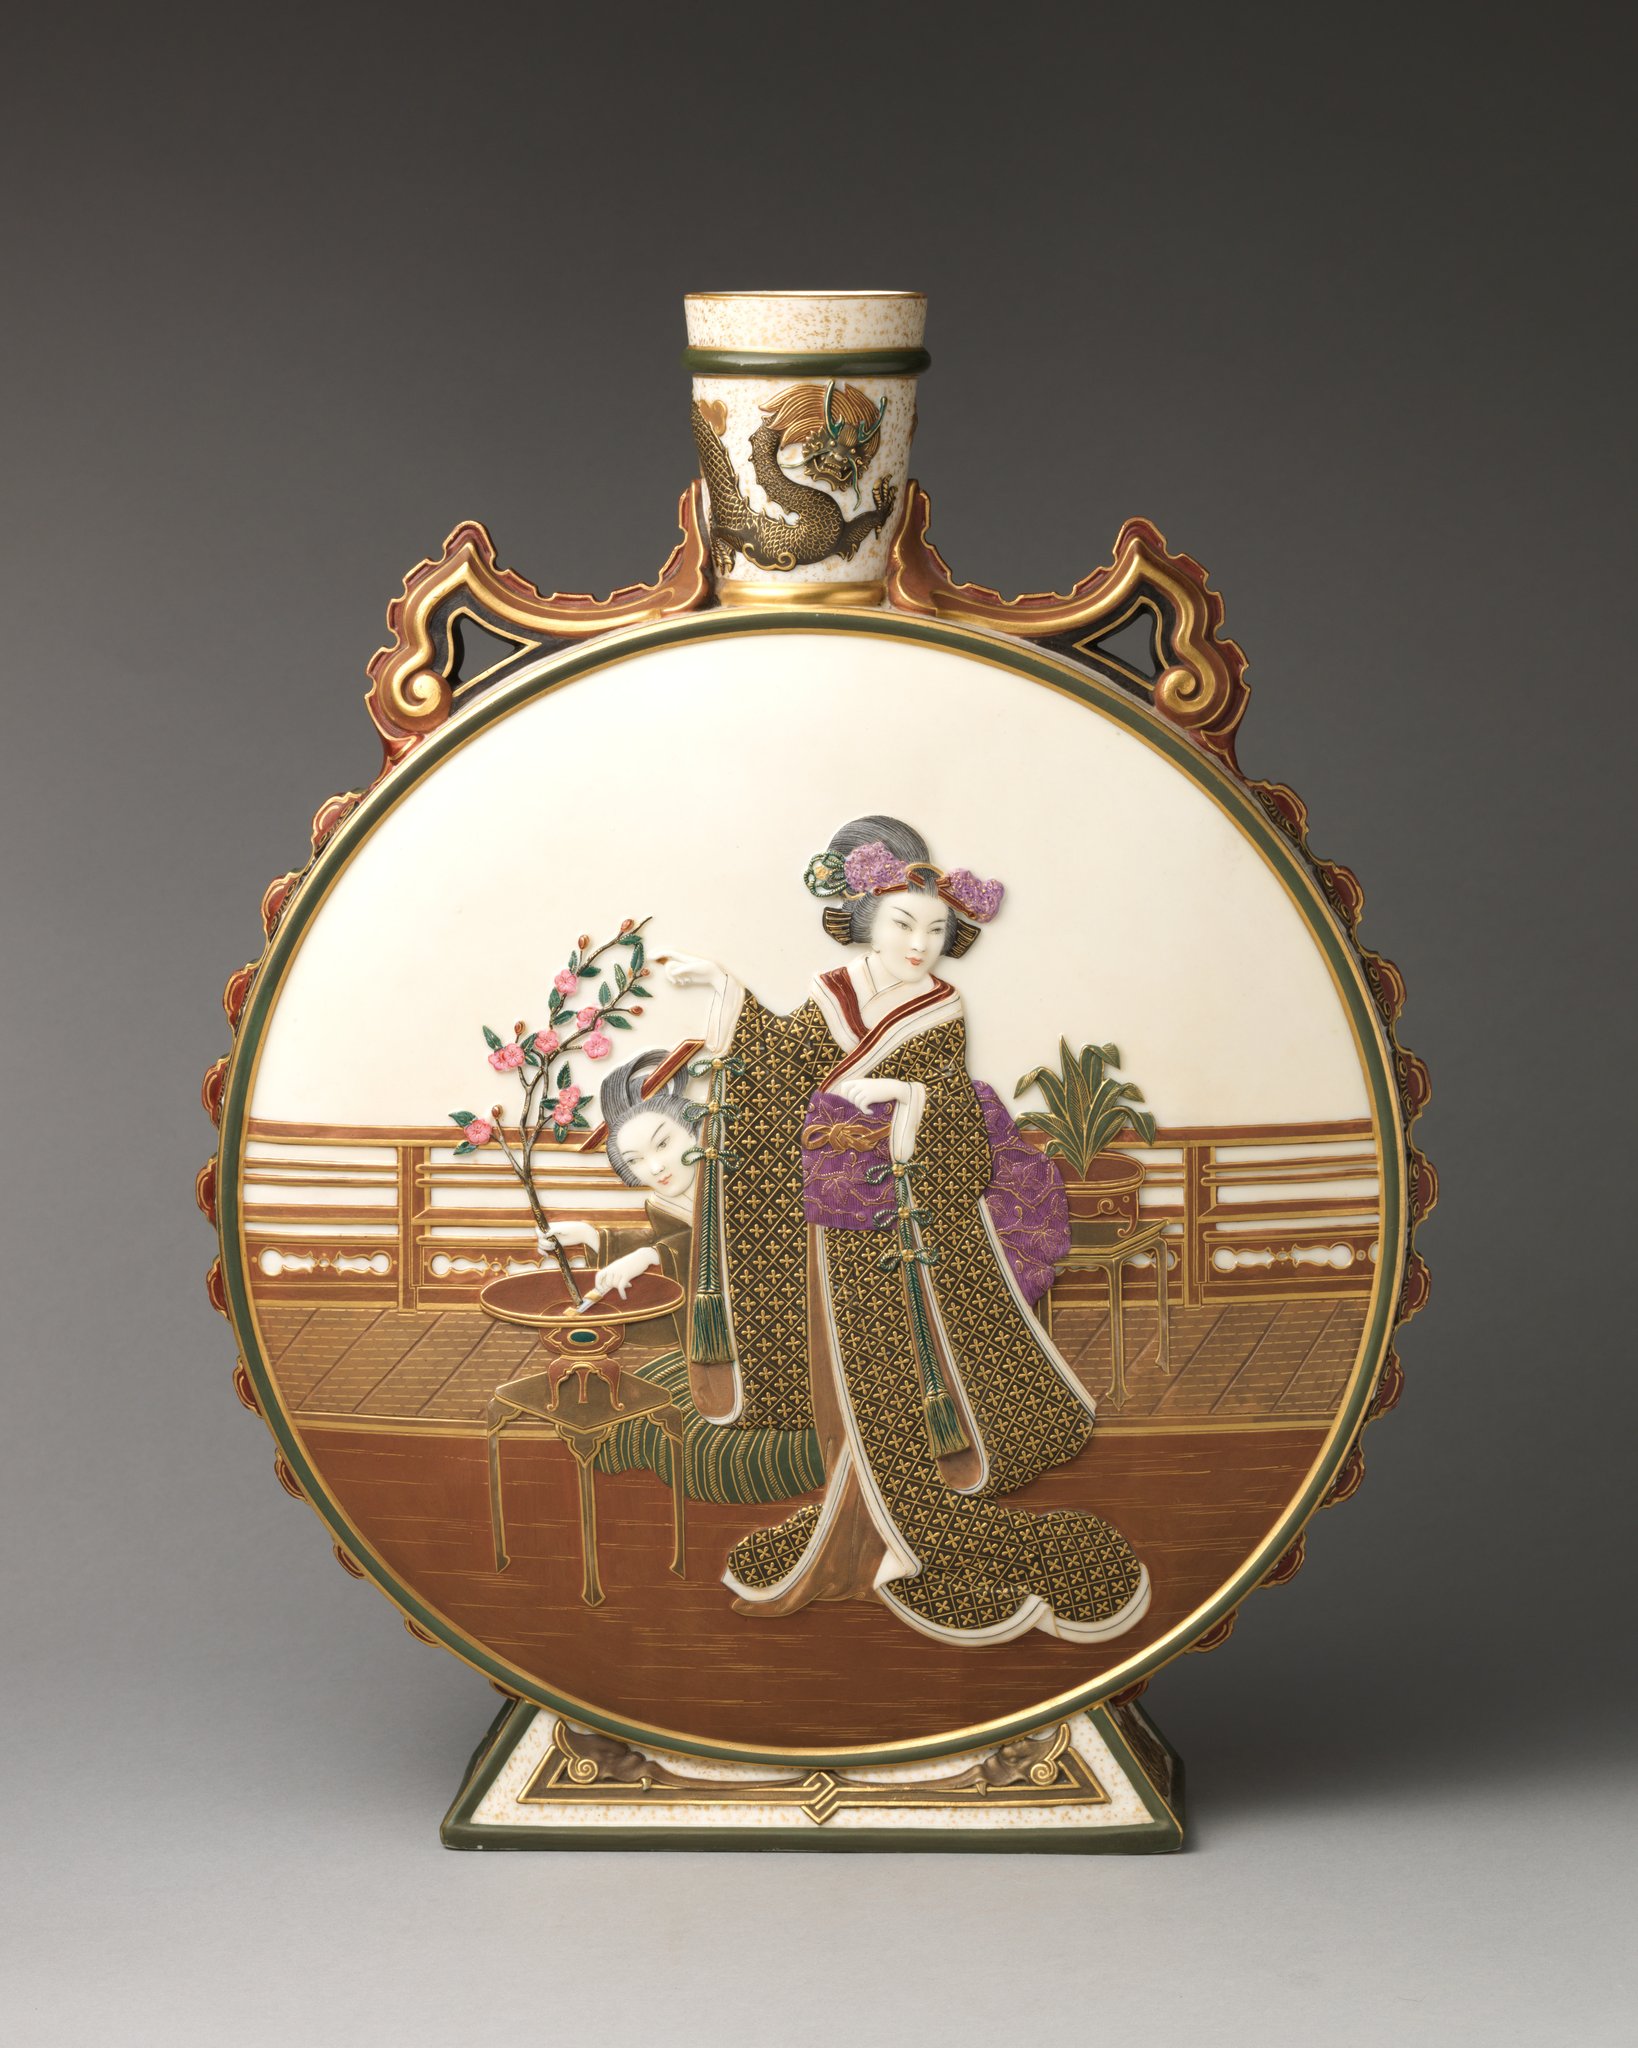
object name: moon flask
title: Moon flask with Japanese woman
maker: worcester factory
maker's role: maker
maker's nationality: british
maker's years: 1751-2008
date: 1872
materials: porcelain